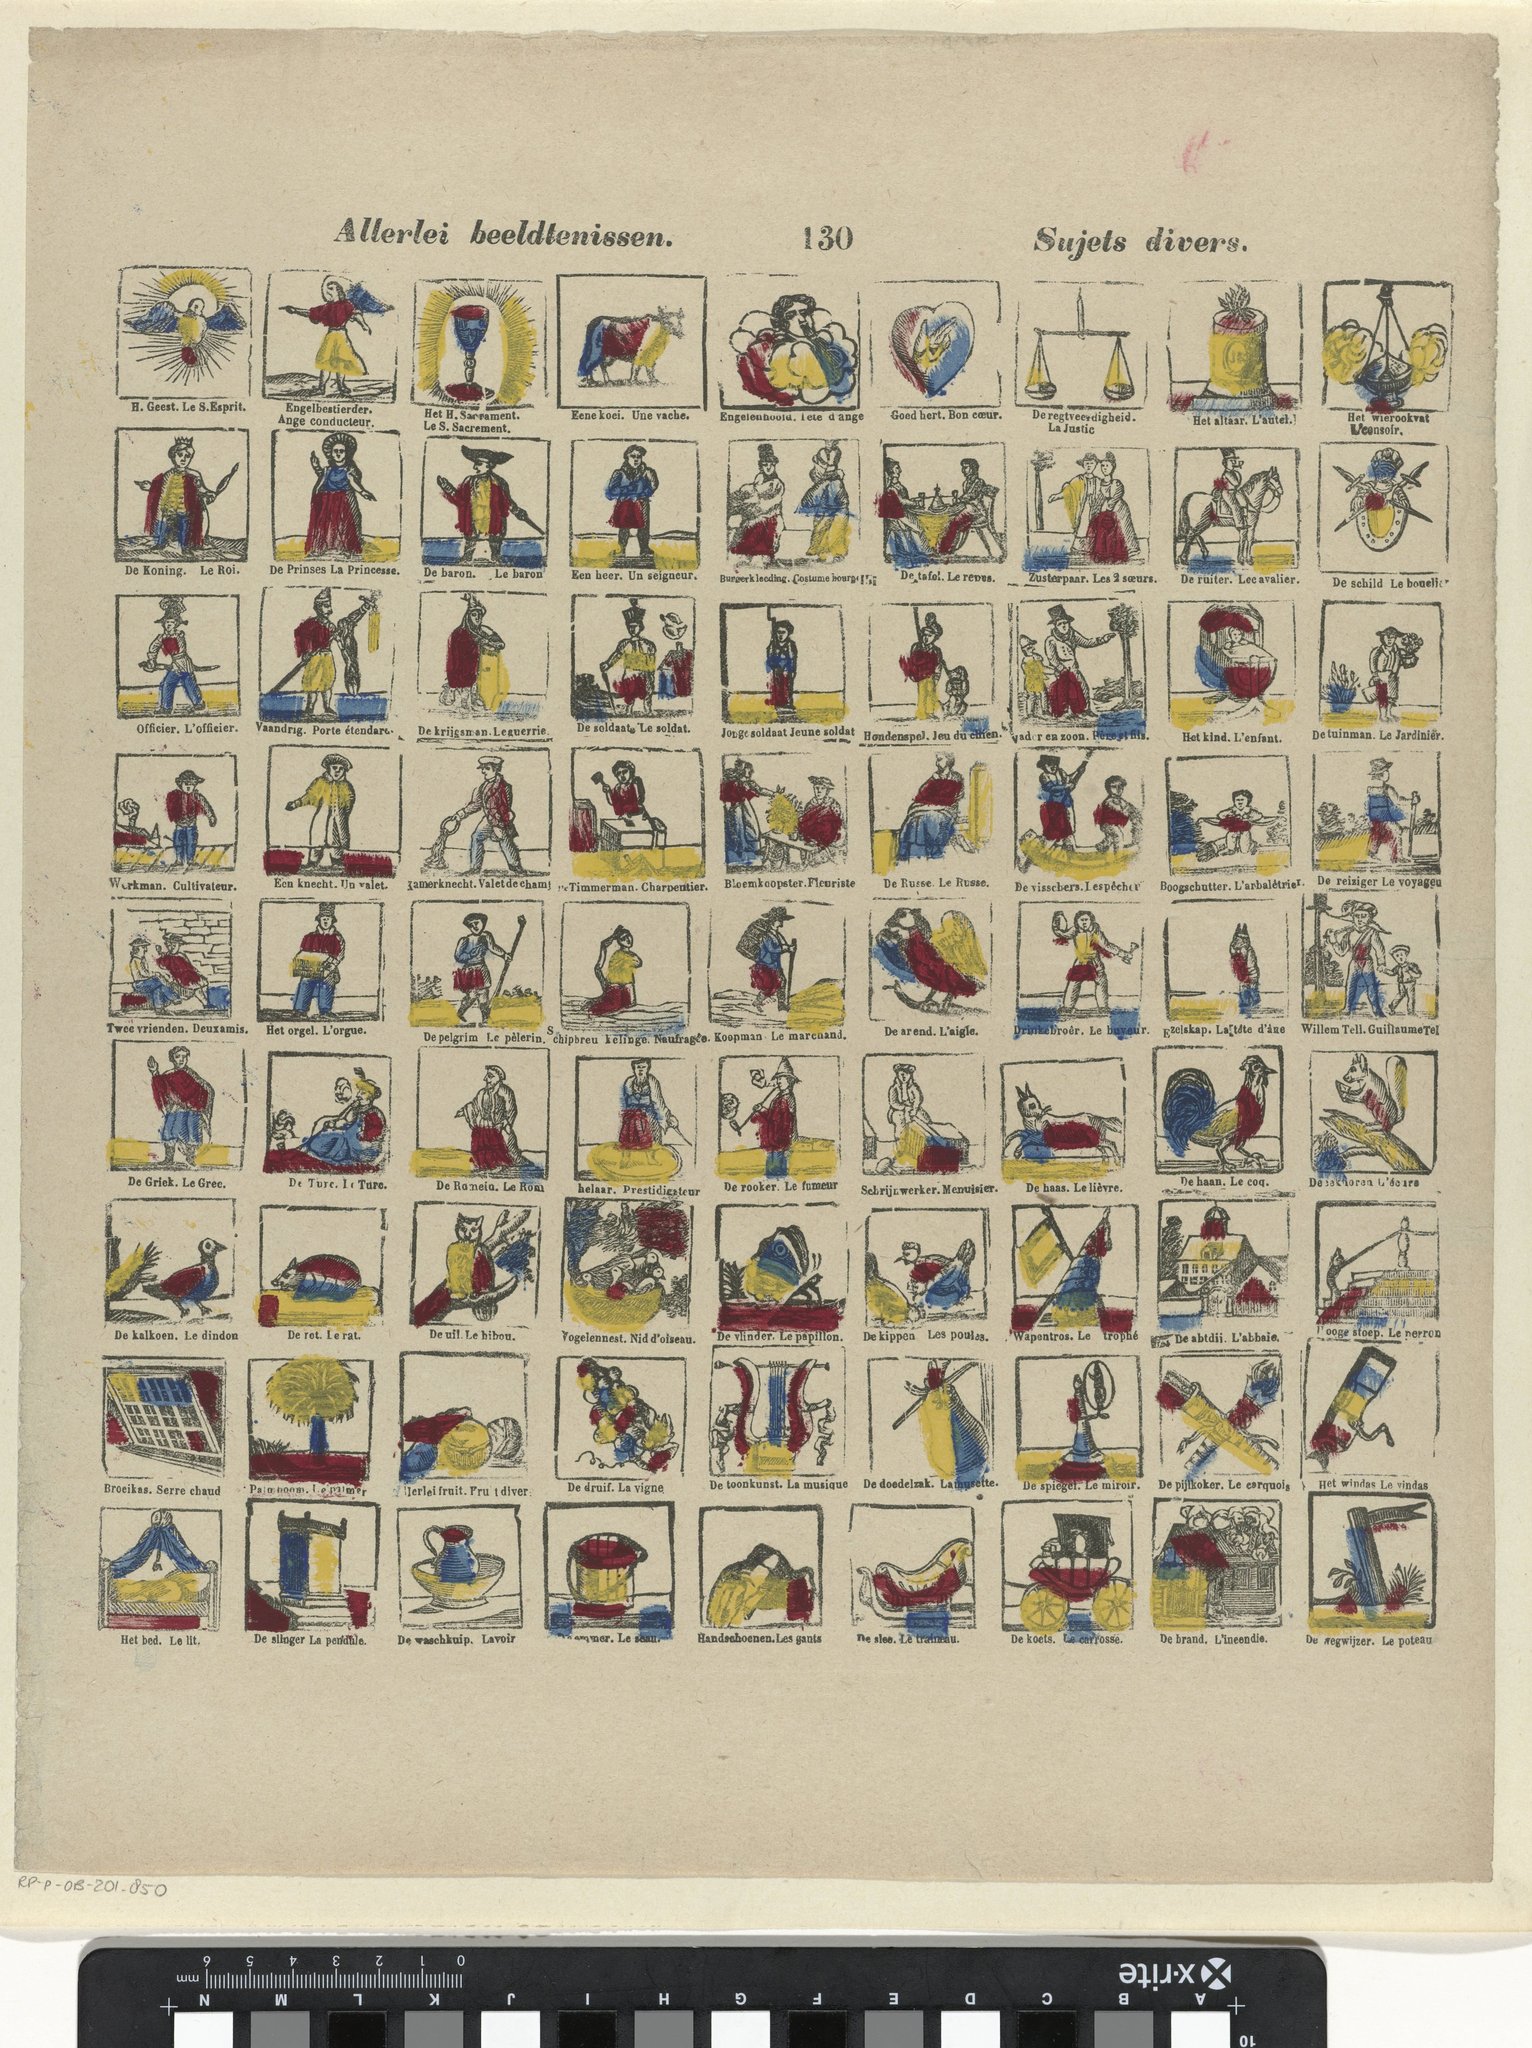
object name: popular print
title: Allerlei beeldtenissen / Sujets divers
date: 1800-1833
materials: paper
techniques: colour, letterpress printing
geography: turnhout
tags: animals, characters (human types)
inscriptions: collector's mark: Lugt 2760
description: Blad met 81 voorstellingen van verschillende voorwerpen, dieren en figuren. Onder elke afbeelding een onderschrift in het Nederlands en in het Frans. Genummerd midden boven: 130.